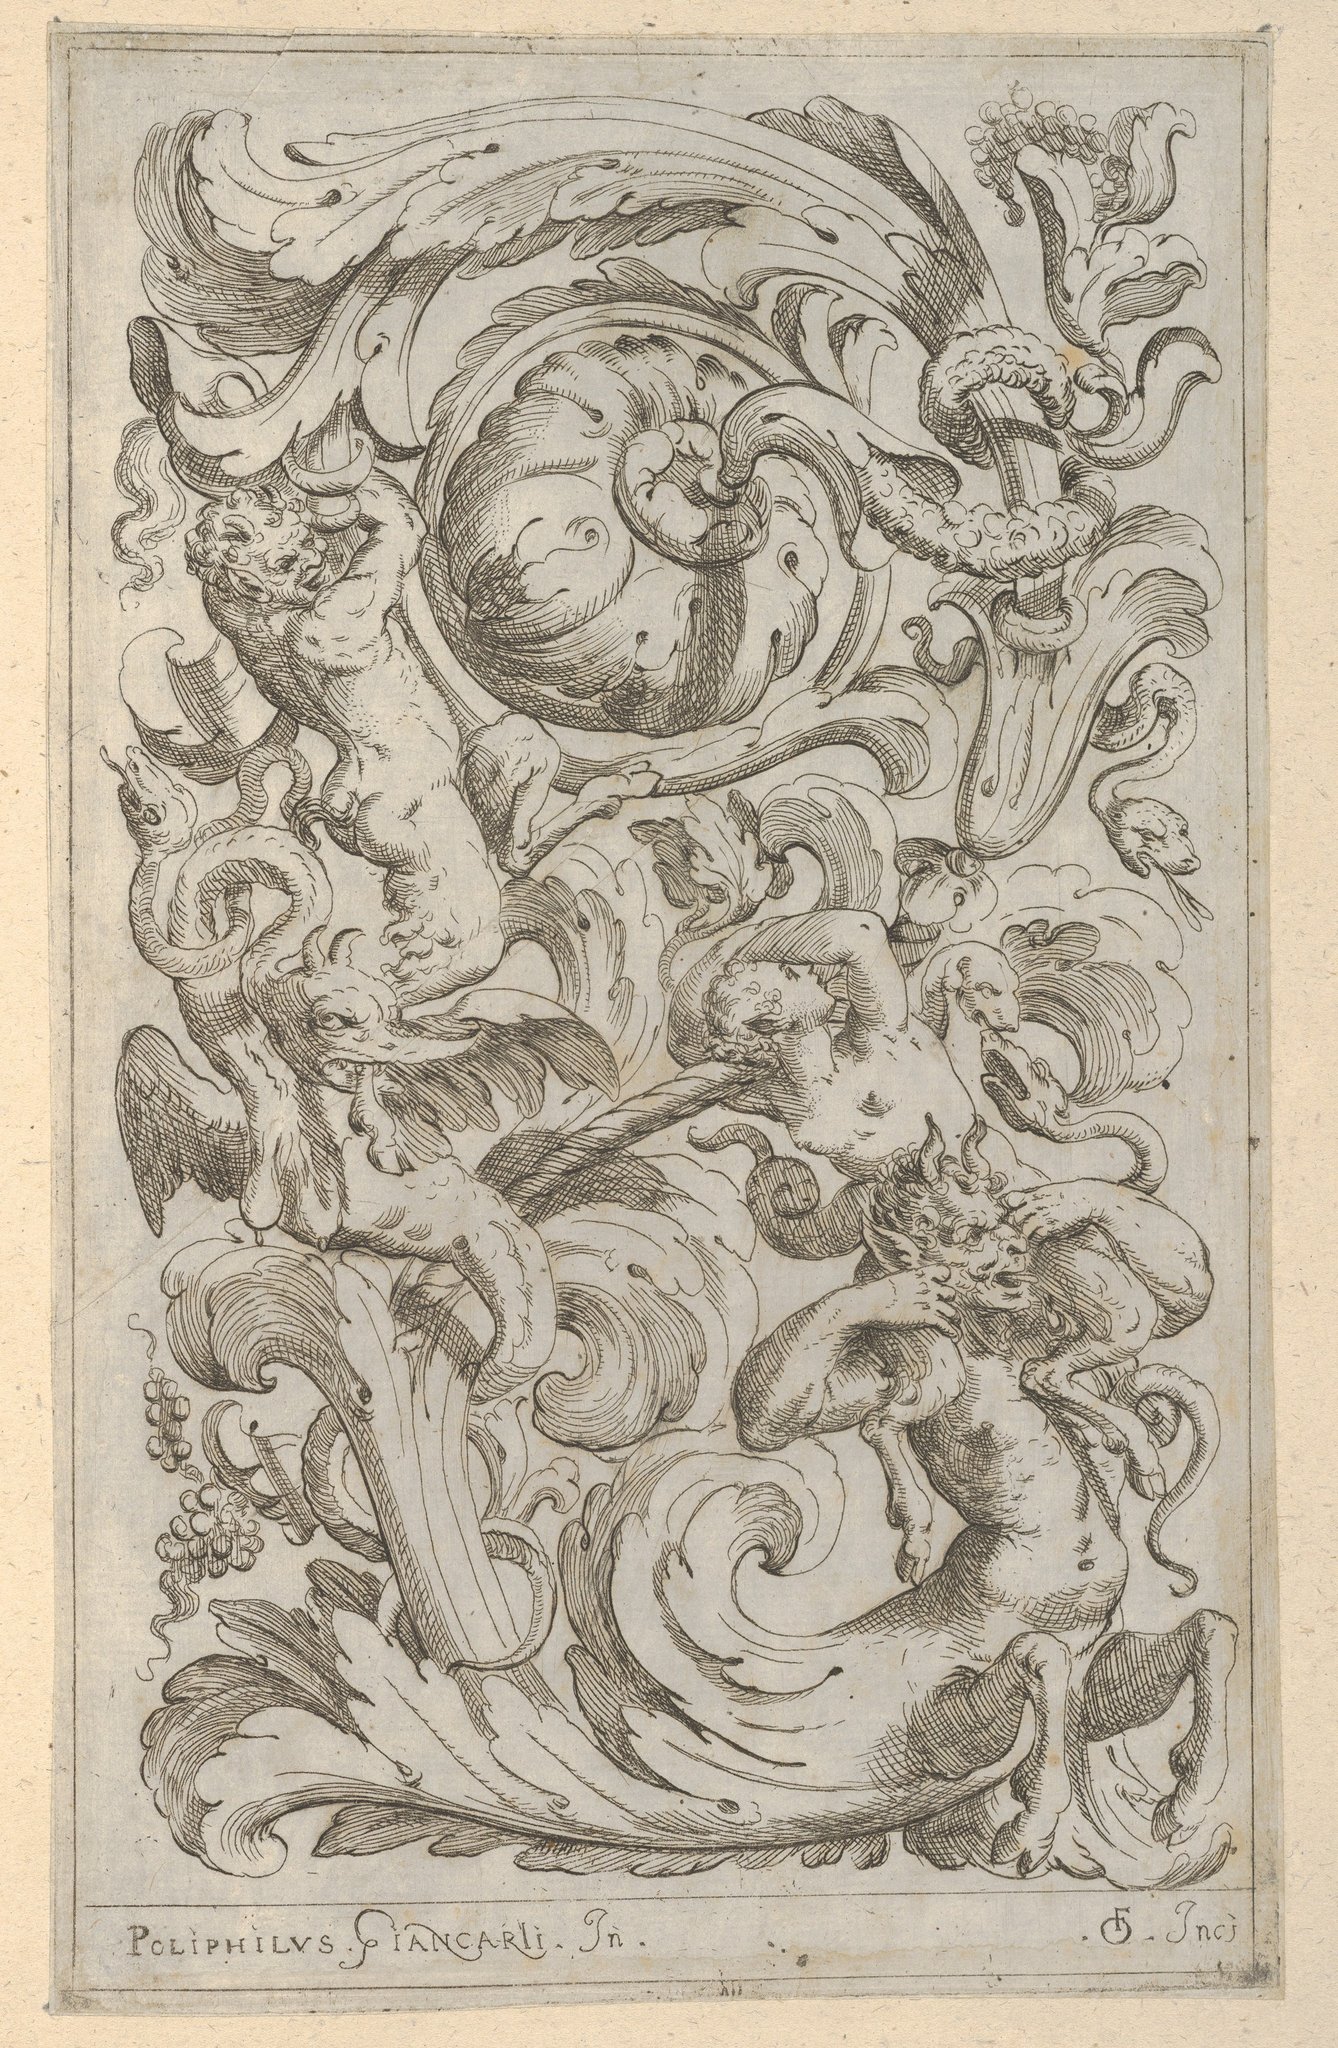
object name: collection ornament architecture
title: Disegni Varii di Polifilo Zancarli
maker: polifilo giancarli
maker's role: artist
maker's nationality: italian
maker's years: 1600-1625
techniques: etching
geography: italy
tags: satyrs,snakes,acanthus